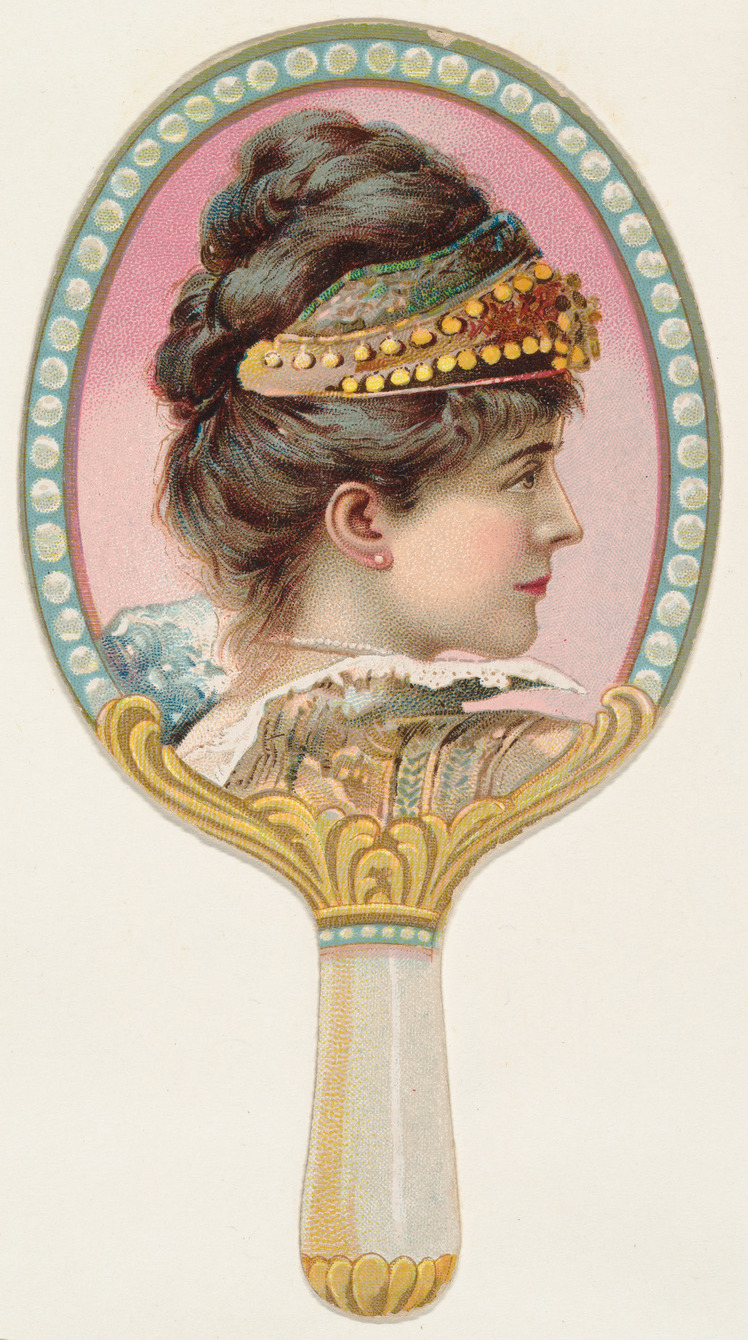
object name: print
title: Hand mirror with woman wearing jewelled headpiece, from the Novelties series (N122) issued by Gail & Ax Tobacco to promote Navy Long Cut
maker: gail & ax tobacco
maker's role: publisher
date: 1889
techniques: color lithograph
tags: profiles,women,mirrors